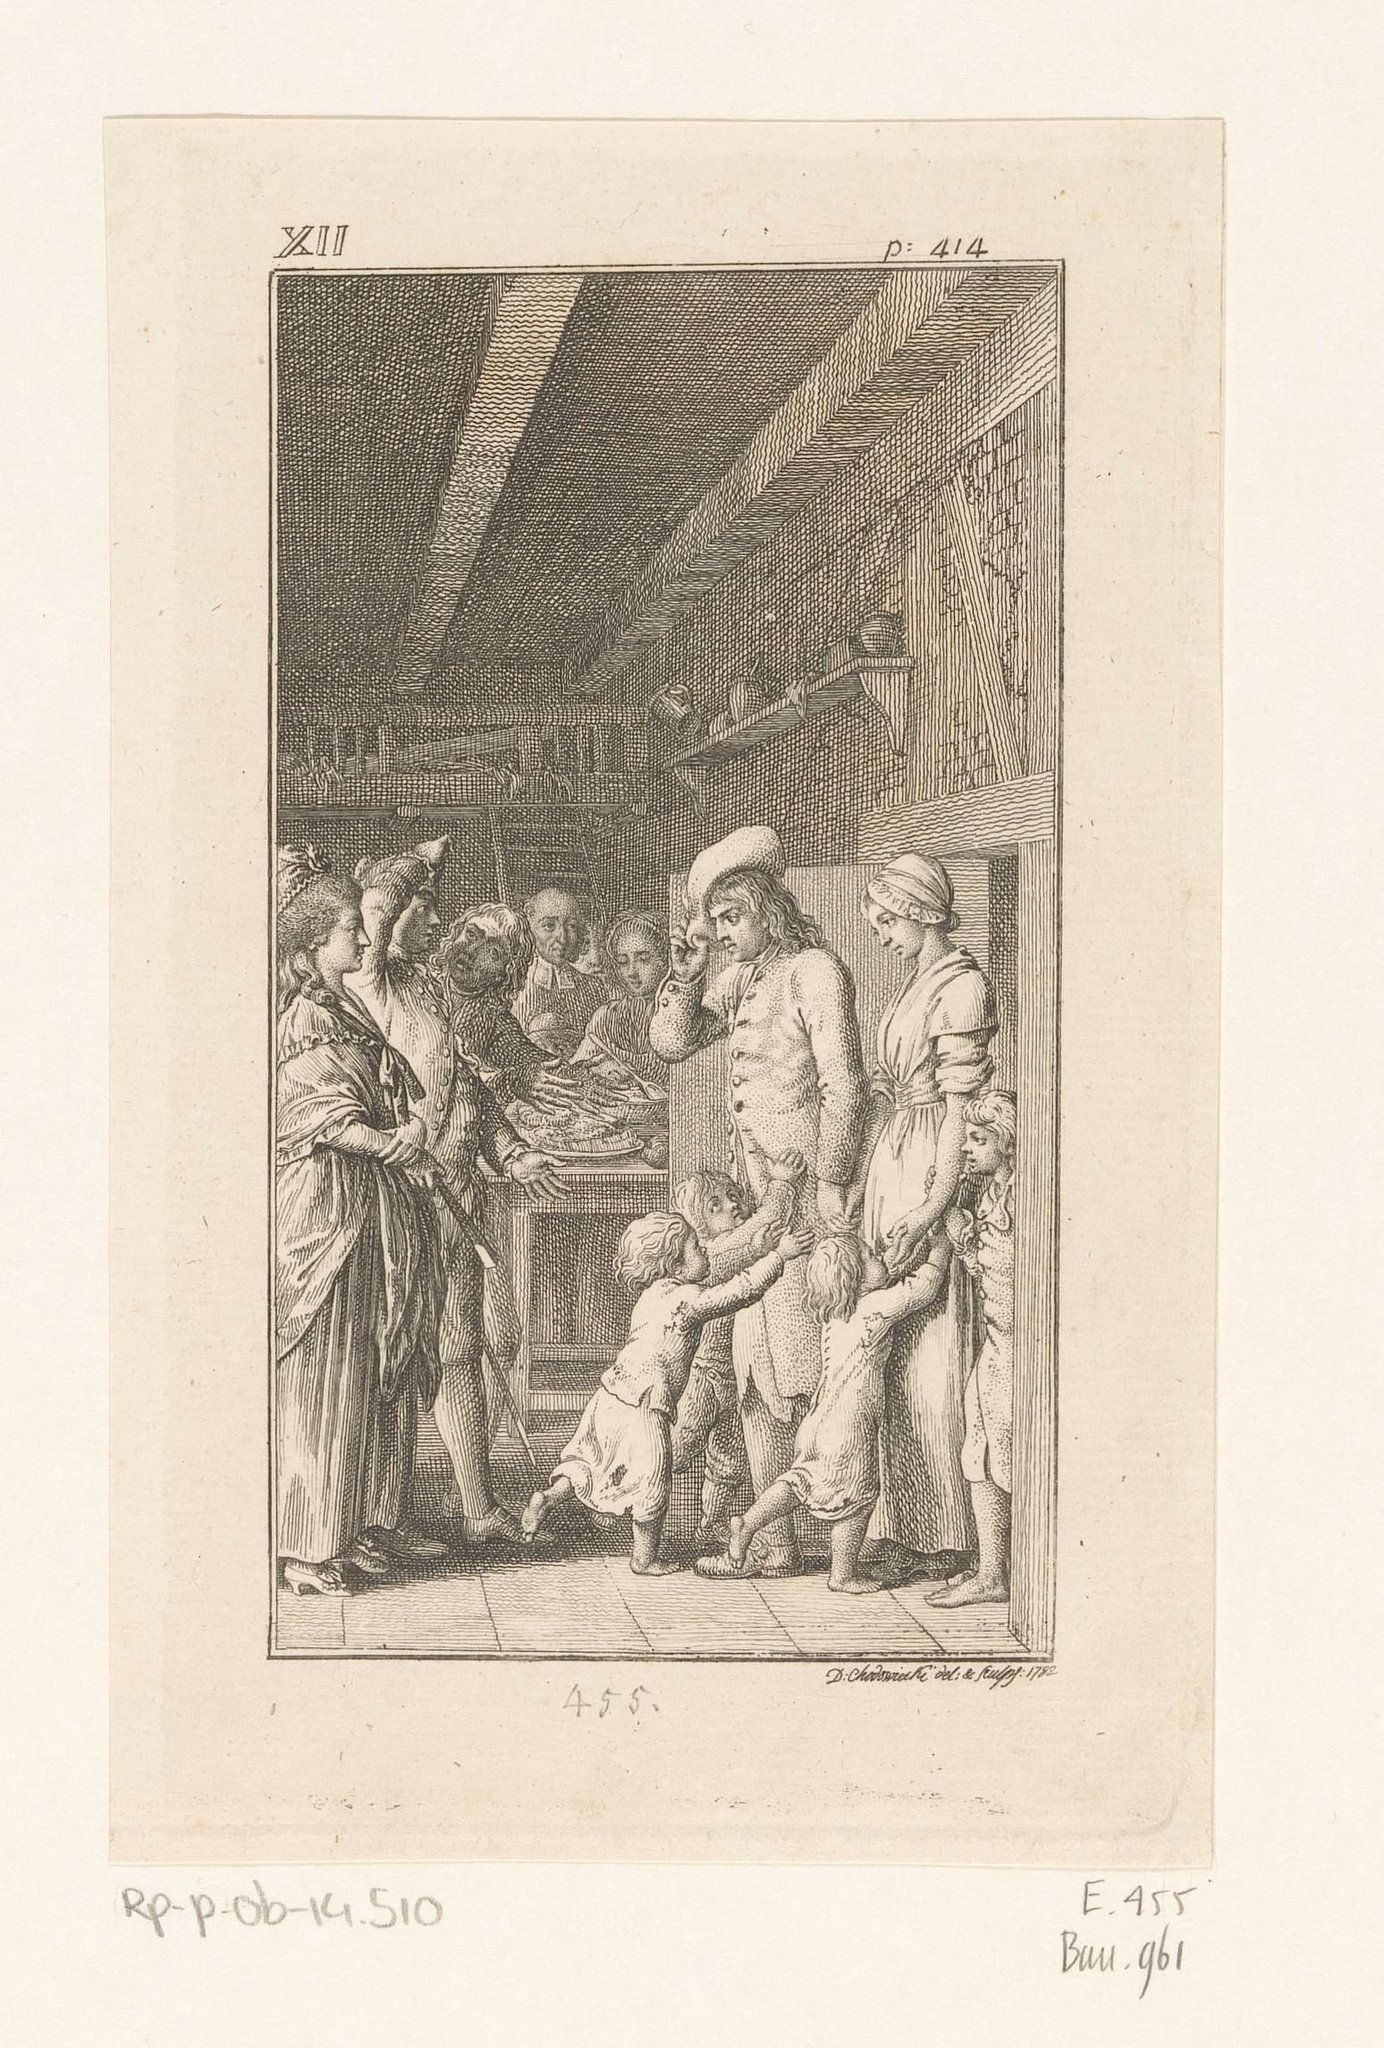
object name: print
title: Leonard en Gertrude worden warm onthaald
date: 1782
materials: paper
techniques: etching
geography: berlin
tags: politician, parents with their children, being welcomed ~ travelling, interior of the house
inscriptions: collector's mark: Lugt 2228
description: Prent gebruikt voor: Pestalozzi, Johann Heinrich. Léonard et Gertrude ou Les moeurs villageoises, telles qu'on les retrouve à la ville & à la cour. Berlijn: George Jacques Decker, 1783.